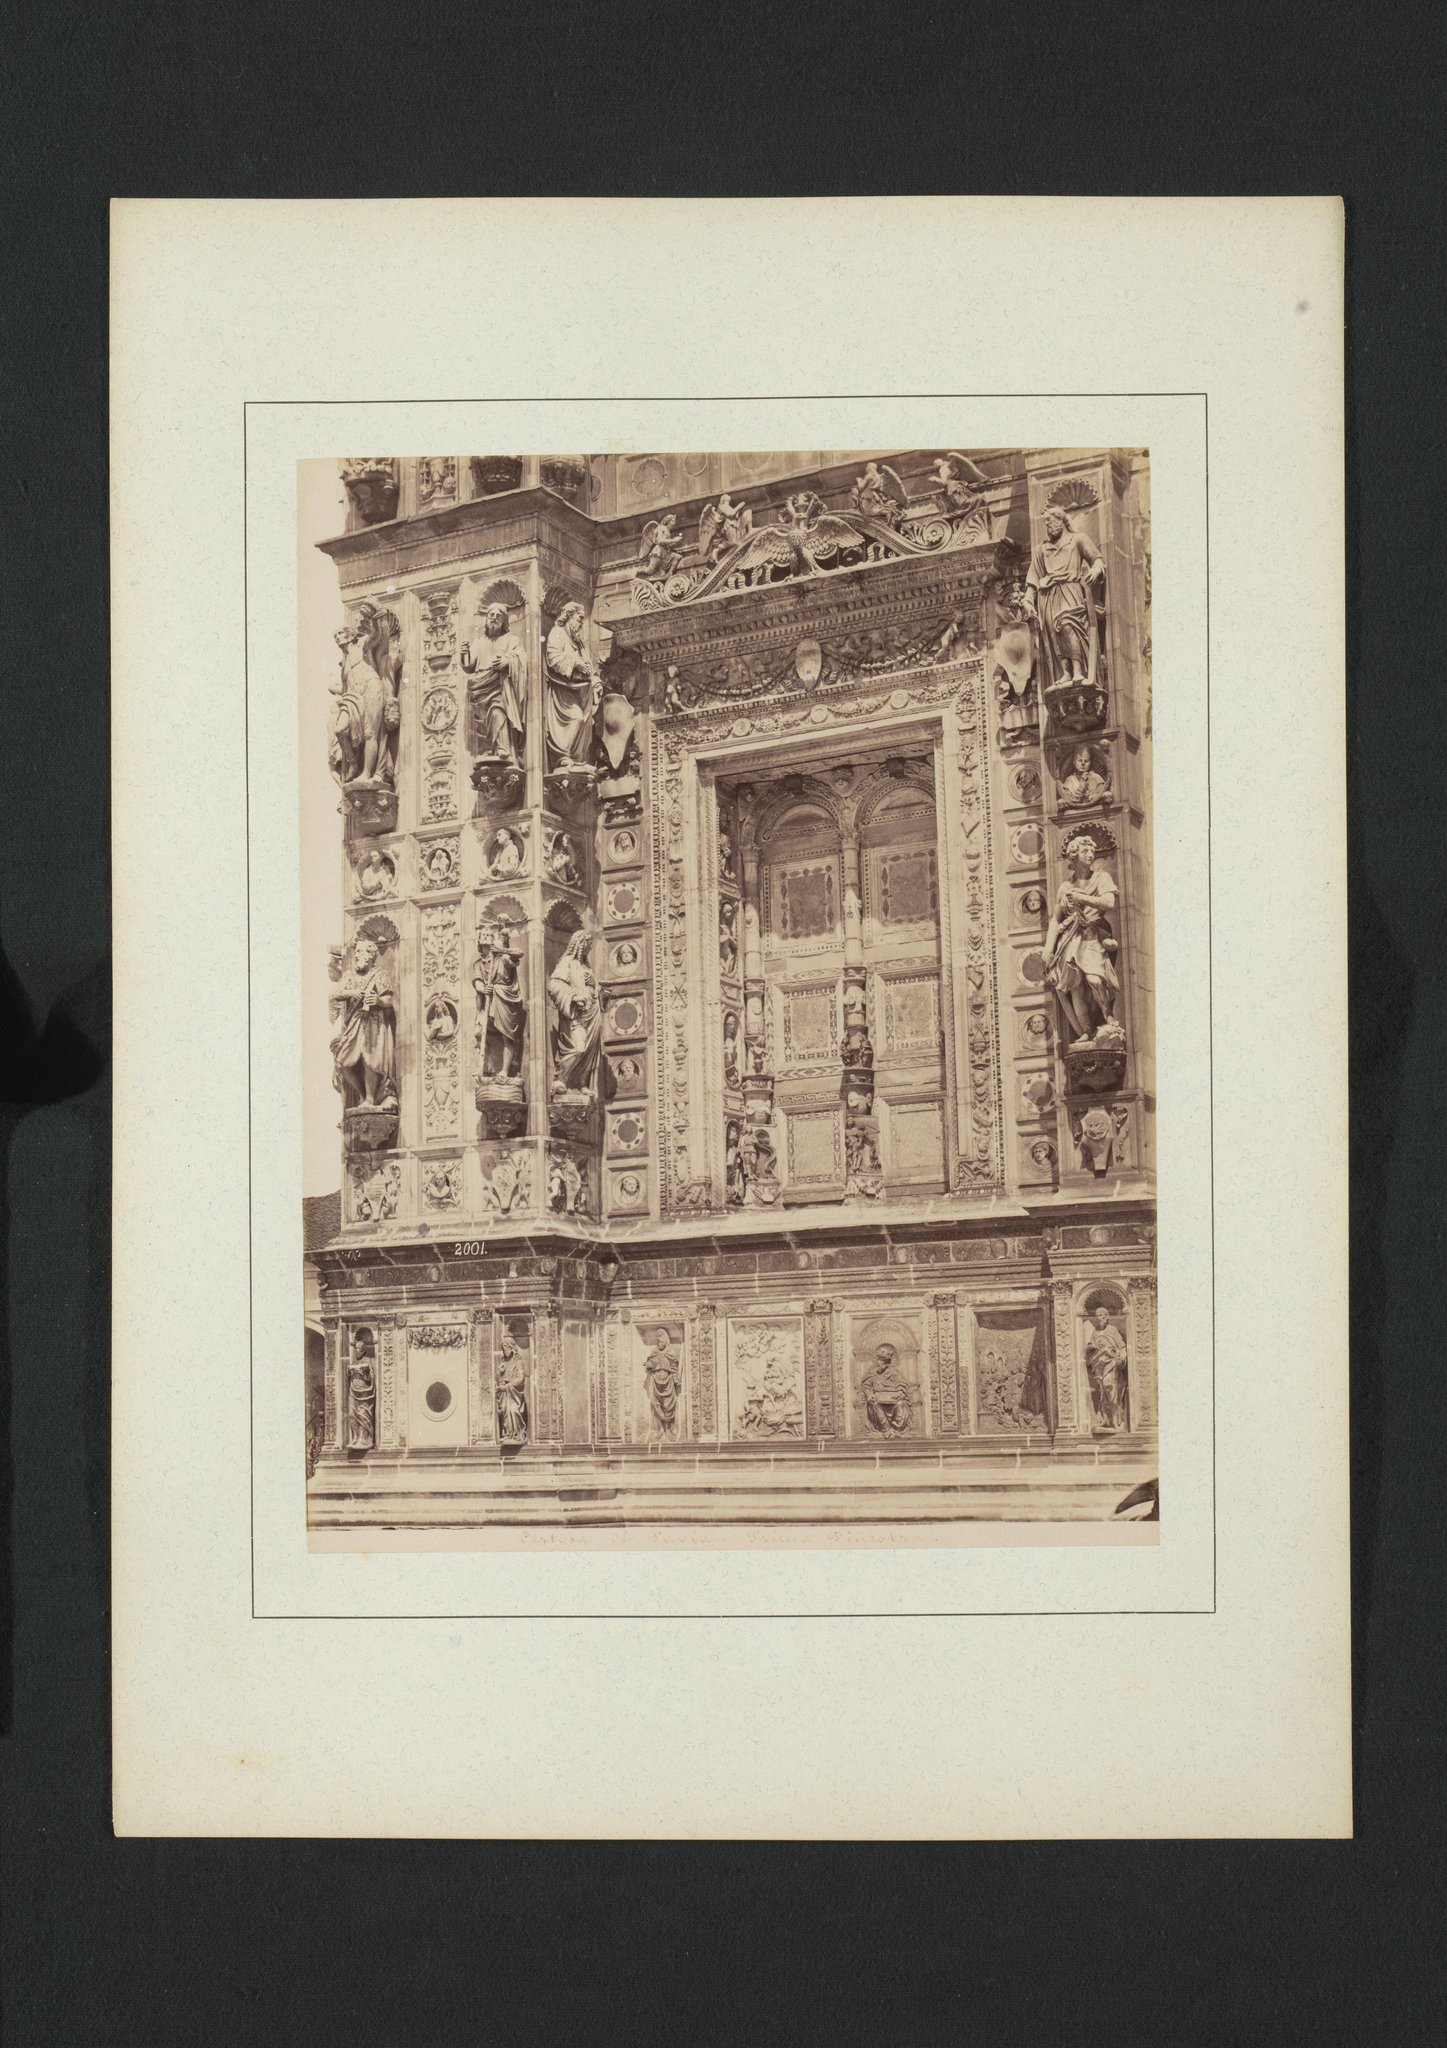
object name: photograph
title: Certosa di Pavia, Primo finestre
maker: alfredo noack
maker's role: fotograaf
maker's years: 1833-1895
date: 1877-1882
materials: cardboard, photographic support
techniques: albumen print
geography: certosa di pavia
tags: window, abbey, monastery, convent ~ roman catholic church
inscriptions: inscription: ‘No. 12. Erstes Fenster.’, number: ‘2001’